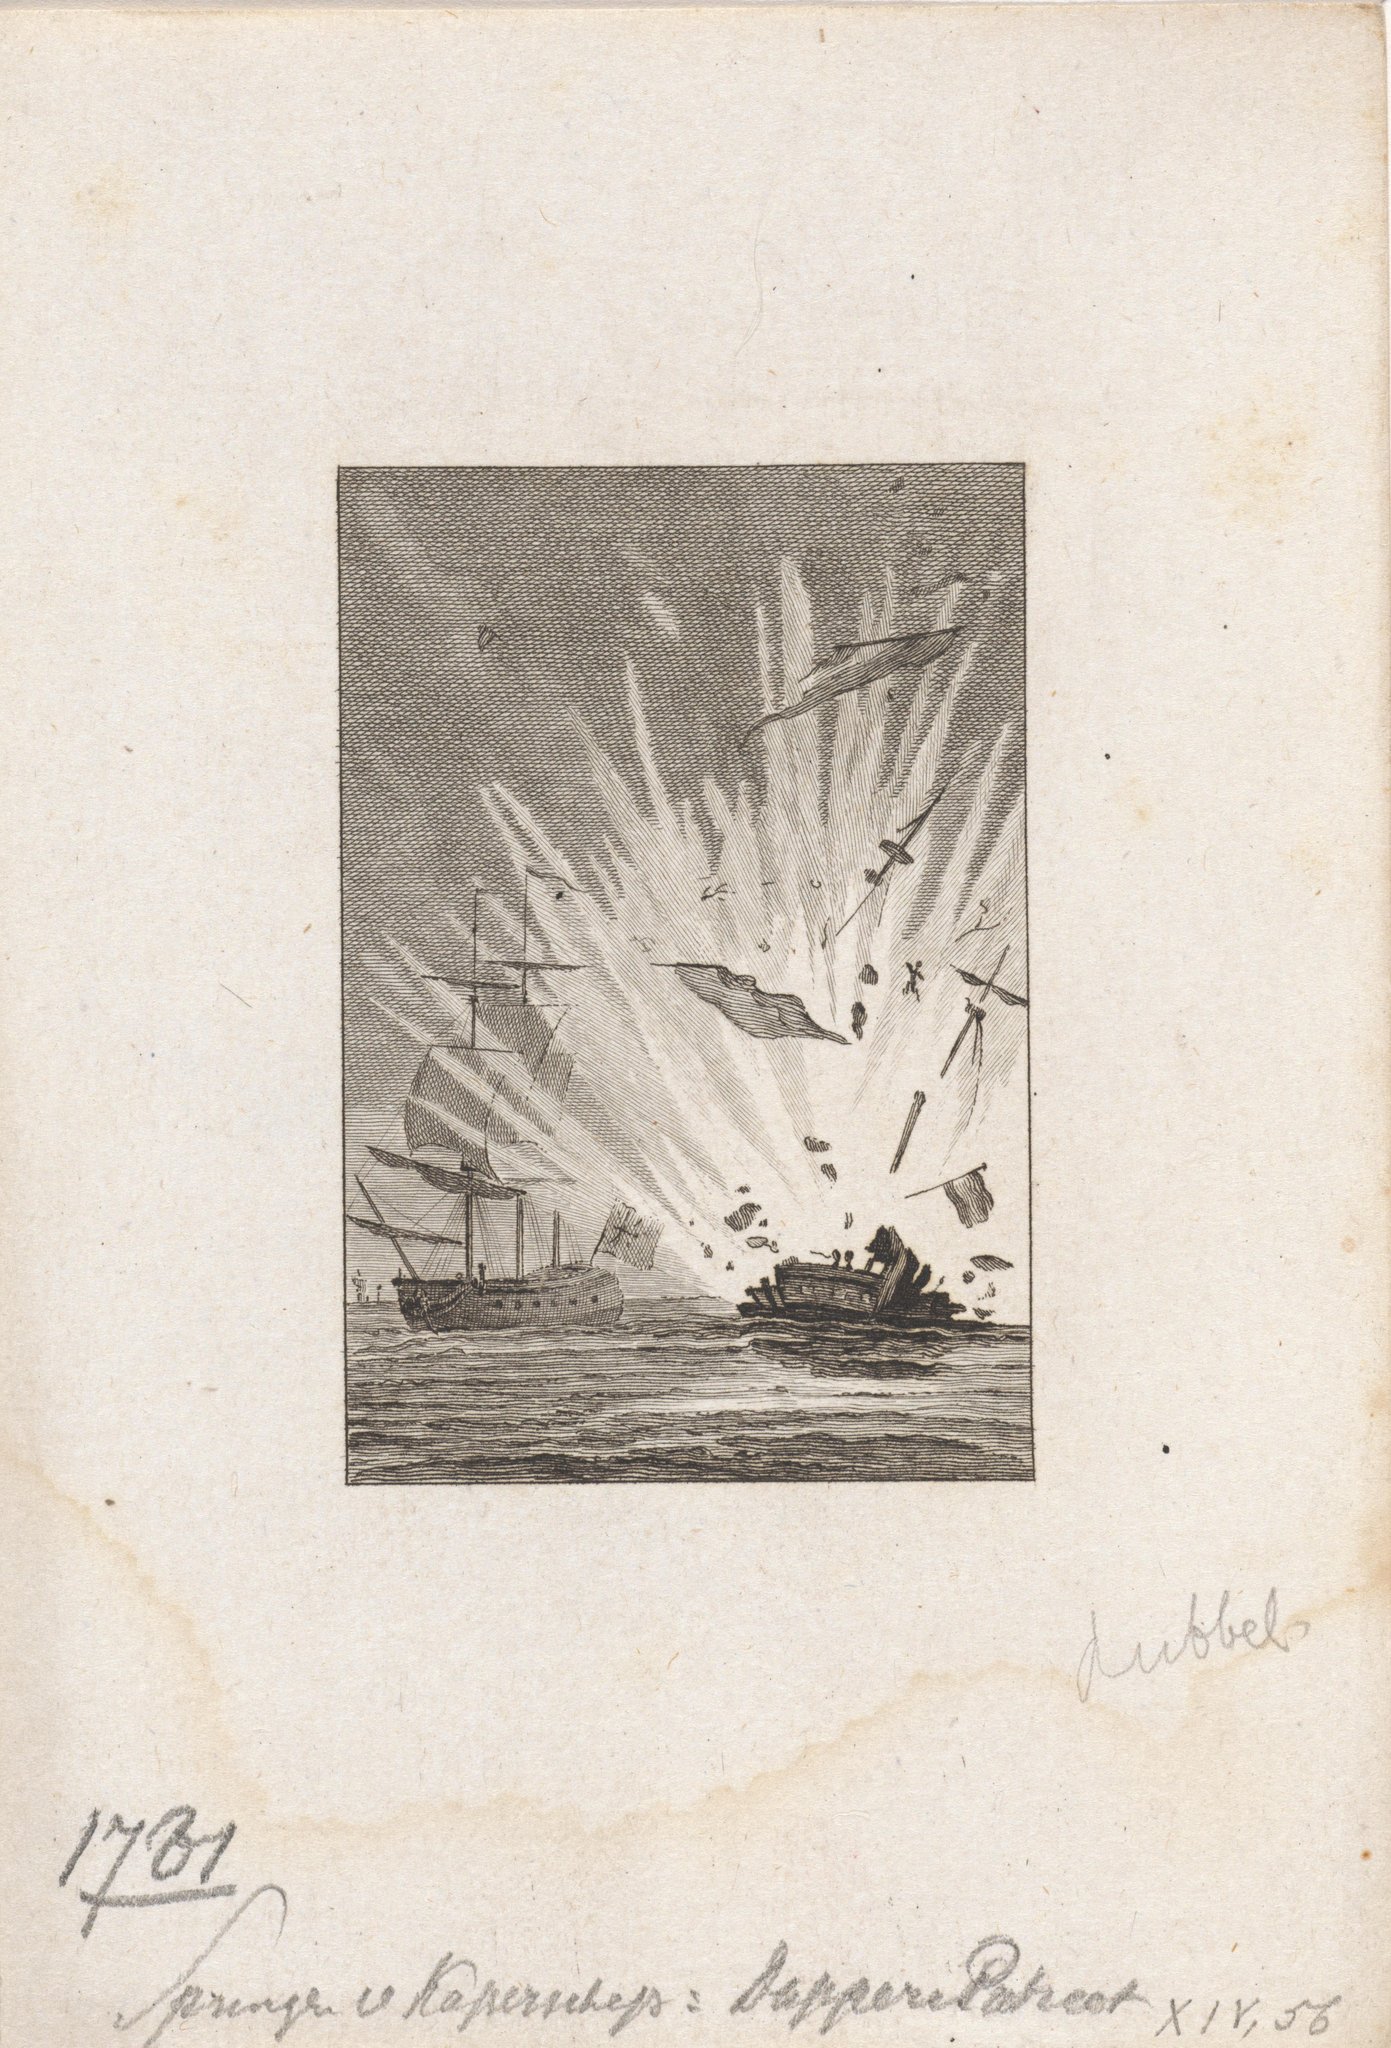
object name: history print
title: Springen van de Haagse Kaper de Dappere Patriot, 1781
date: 1783-1795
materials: paper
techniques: engraving, etching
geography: amsterdam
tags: gunpowder disaster (+ sailing-ships), shipwreck (+ propulsion of vehicle, ship, etc. by wind), fourth anglo-dutch war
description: Illustratie voor: J. Fokke. Geschiedenissen der Vereenigde Nederlanden voor de vaderlandsche jeugd. Amsterdam: Johannes Allart, 1783-1795, 25 delen. deel XIV pl. IX.